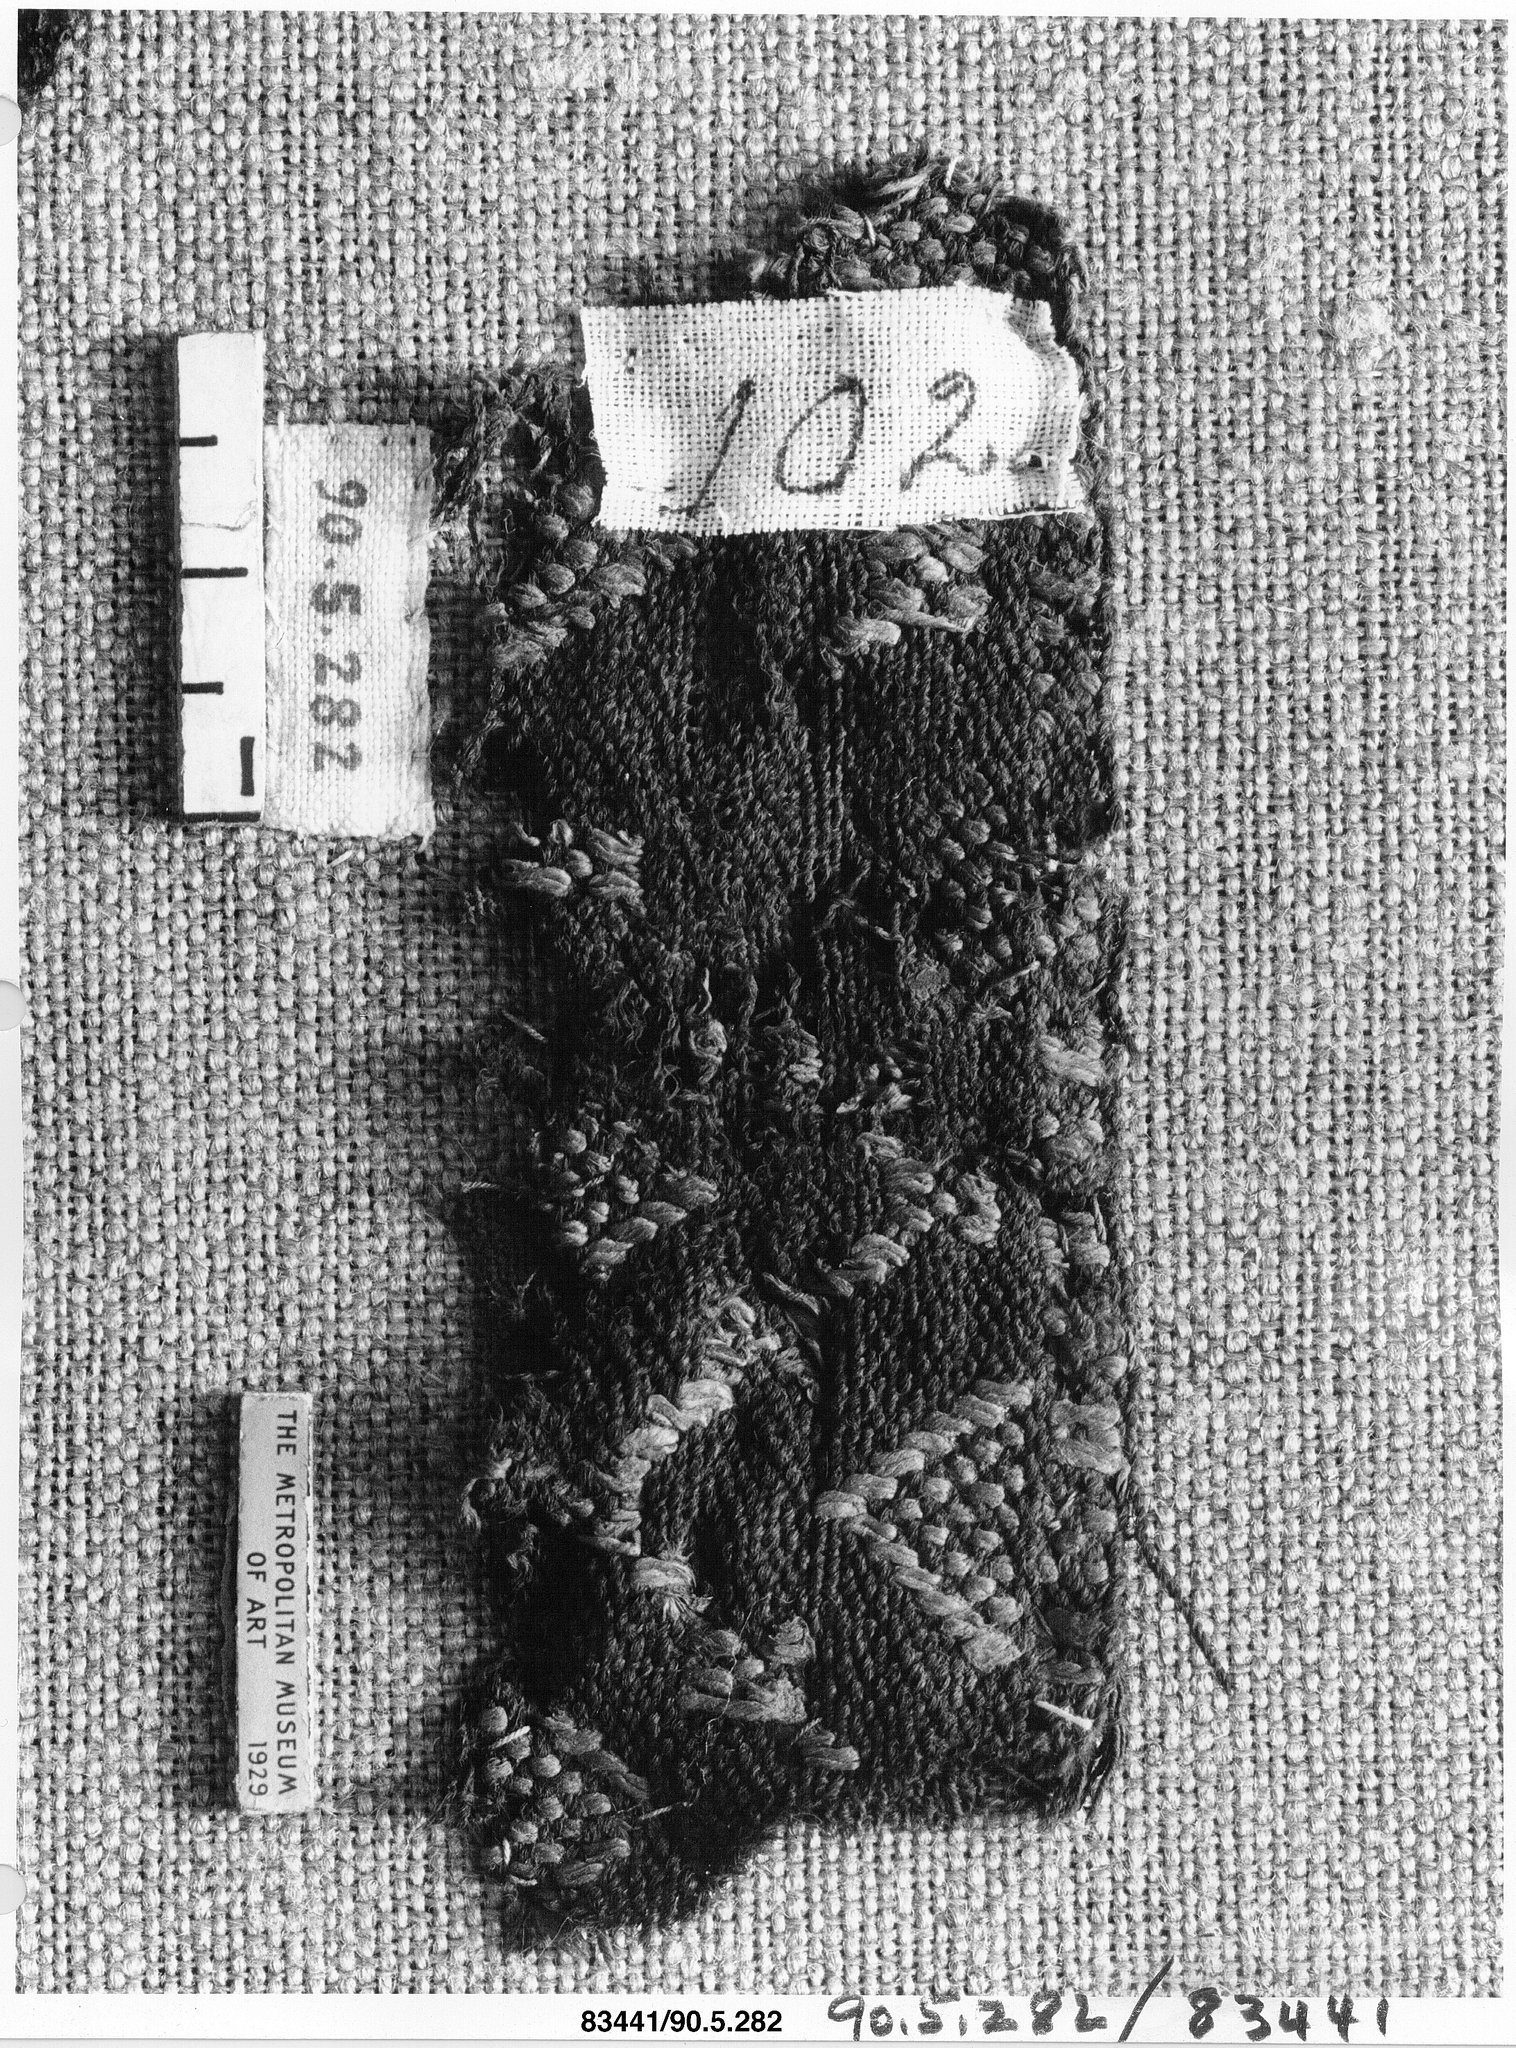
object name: textile fragment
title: Fragment of a Band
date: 401-600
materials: linen, wool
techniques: weave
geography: egypt